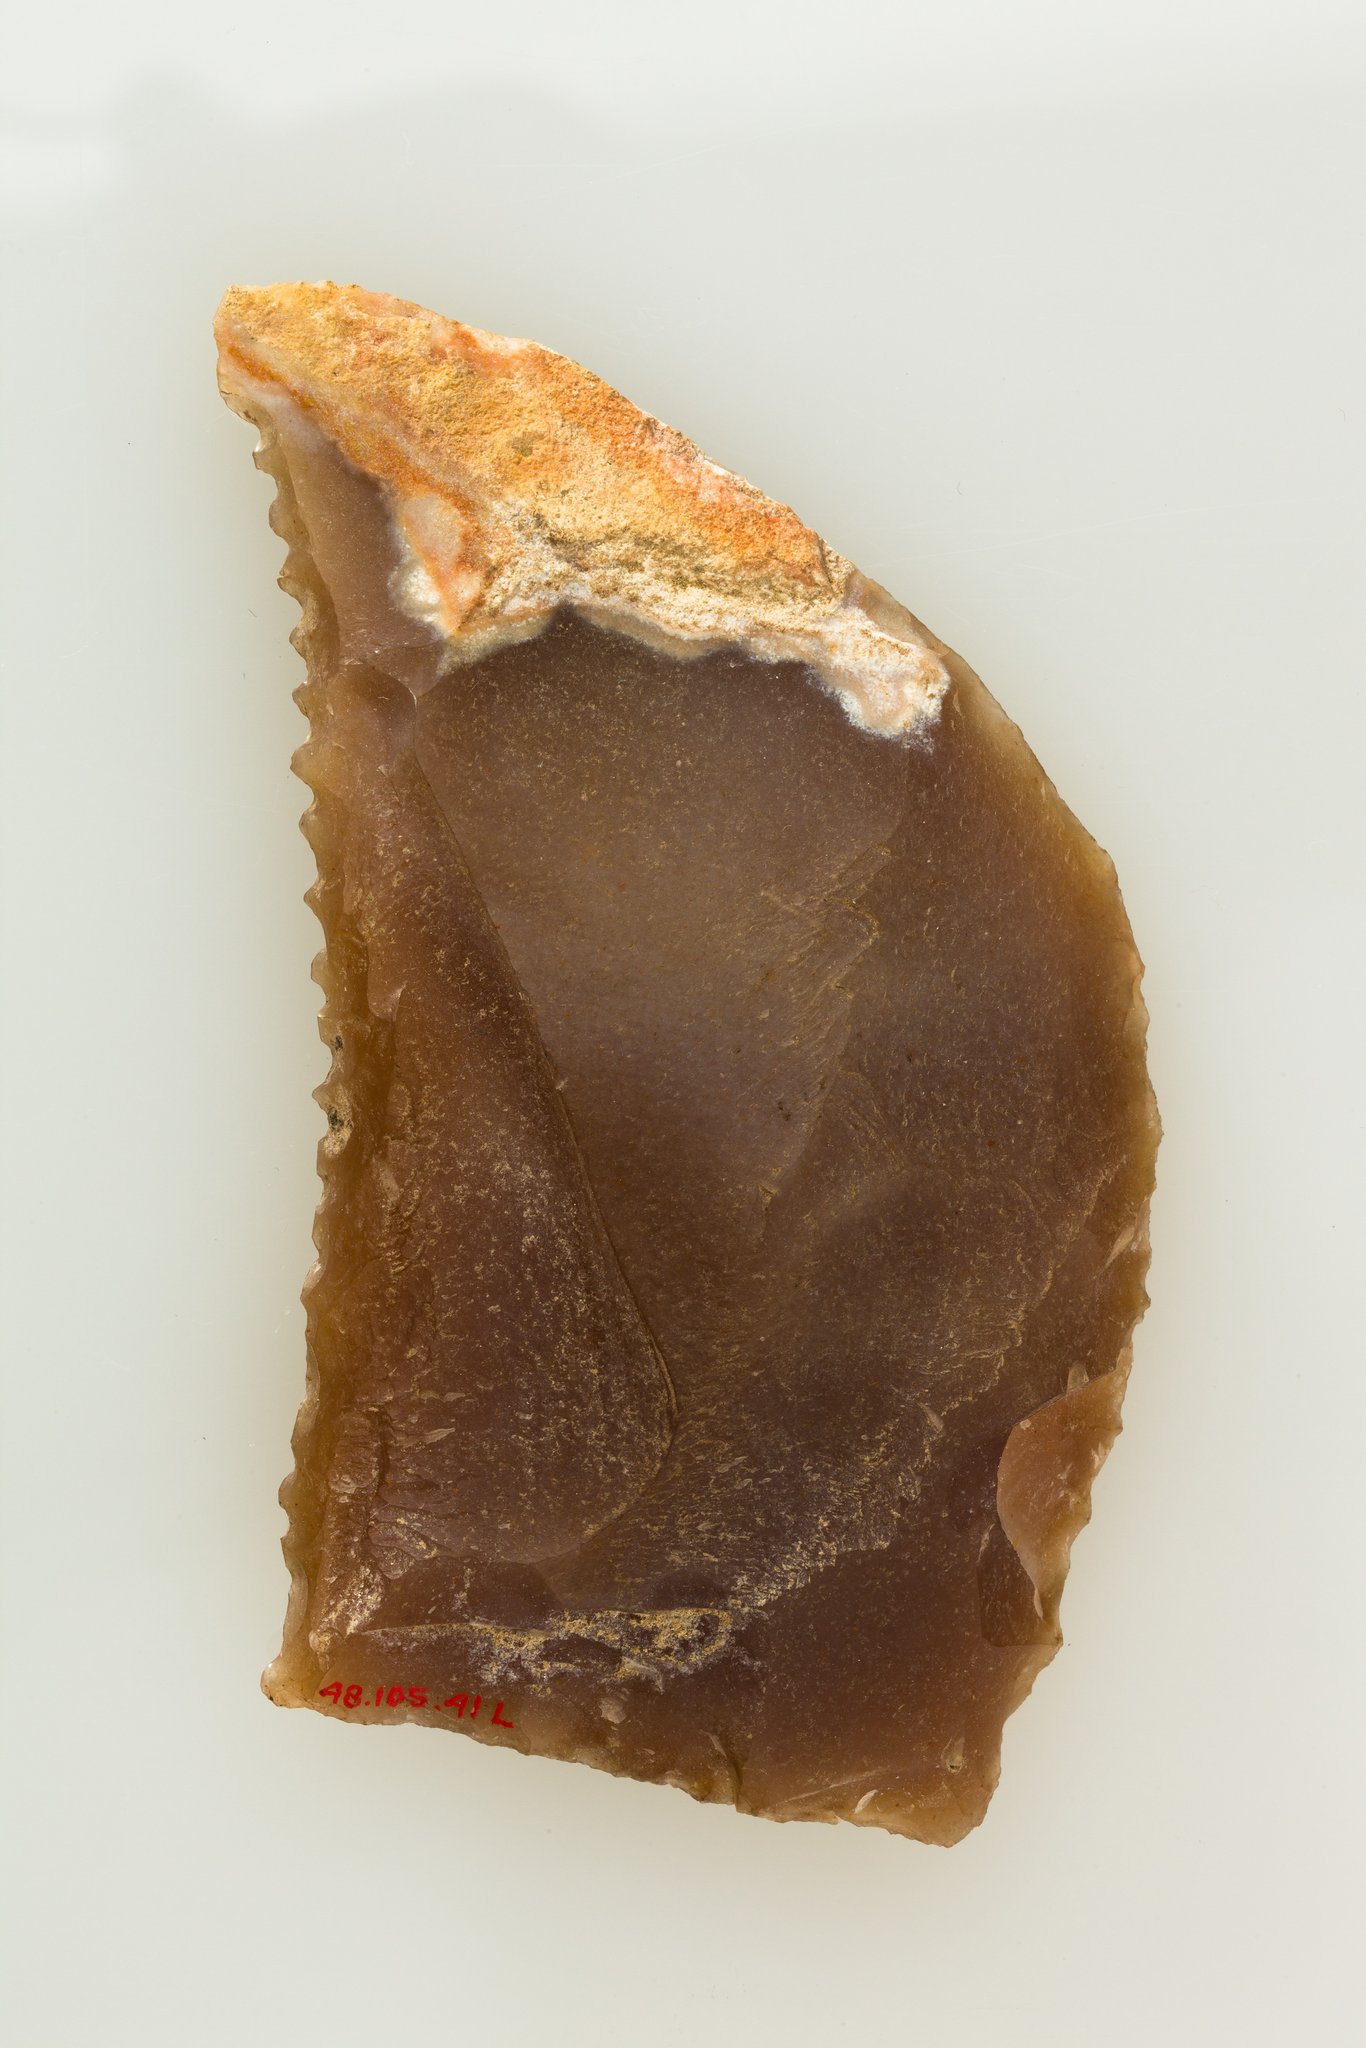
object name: sickle, denticulate, truncated, backed, geometric, tool, element, adhesive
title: Sickle Insert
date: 1184-664 BCE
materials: stone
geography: egypt